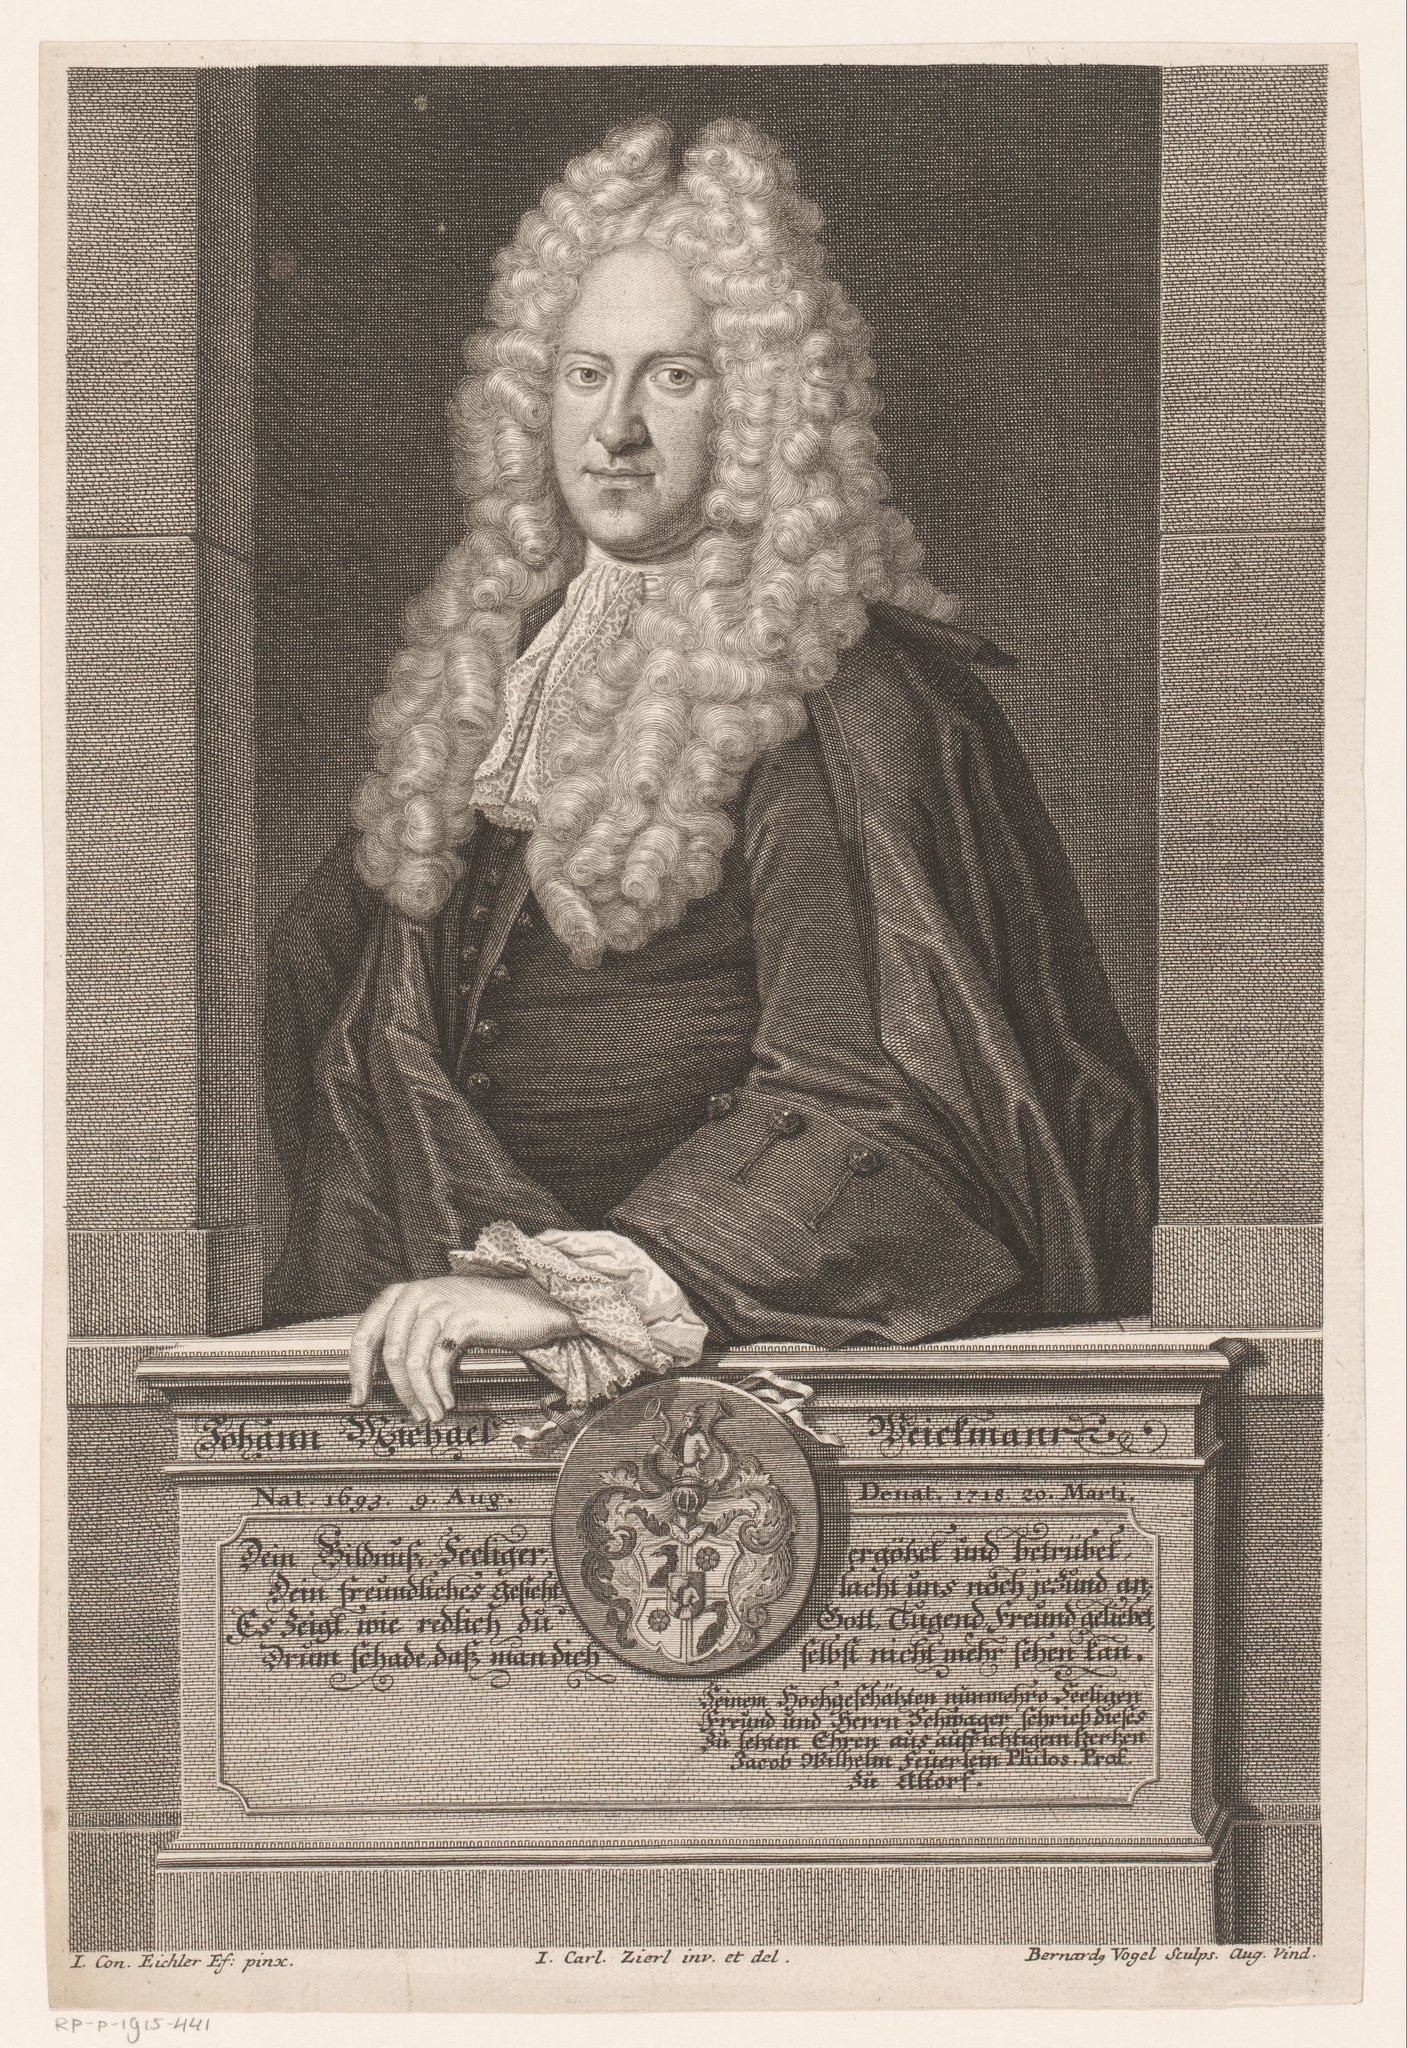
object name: print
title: Portret van Johann Michael Weickmann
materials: paper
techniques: engraving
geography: augsburg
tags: historical persons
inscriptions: collector's mark: Lugt 2228